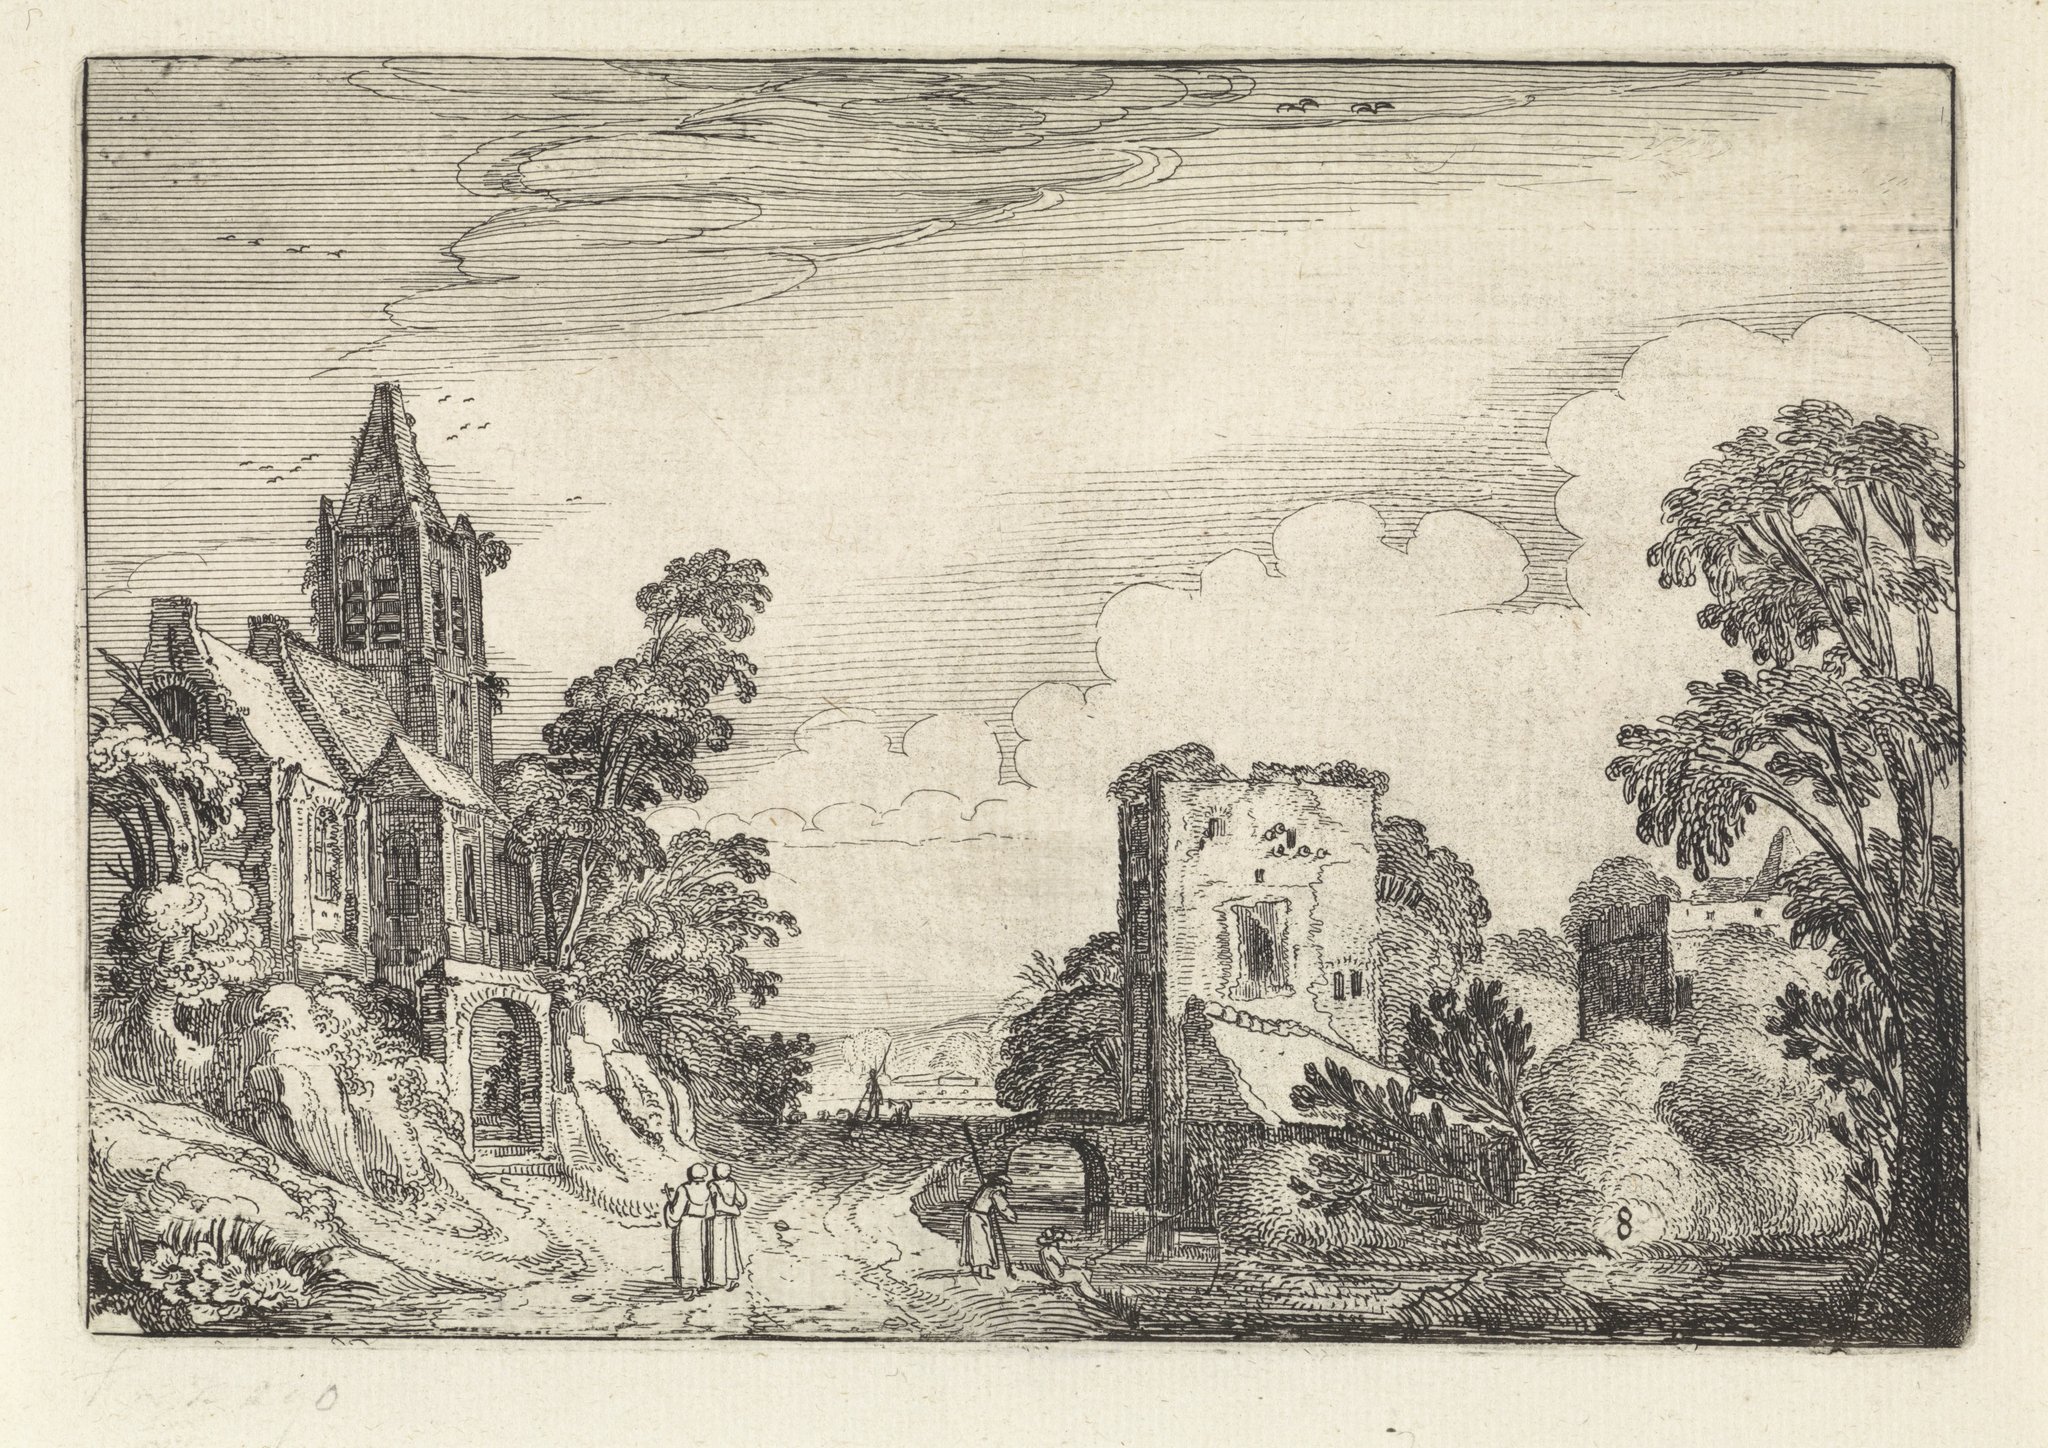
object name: print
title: Landschappen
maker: jan van de velde (ii)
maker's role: draughtsman, painter, print maker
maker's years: 1593-1641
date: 1616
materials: paper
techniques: etching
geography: northern netherlands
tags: landscape with bridge, viaduct or aqueduct, landscape with tower or castle, angling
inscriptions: number: ‘8’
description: Een hengelaar en een tweede figuur aan de oever van een stroom bij een toren in een landschap. Voor de toren een stenen brug. Links een kerk en op het pad ervoor twee geestelijken. Achtste prent van deel twee van een serie van in totaal zestig prenten met landschappen, verdeeld over vijf delen van elk twaalf prenten.